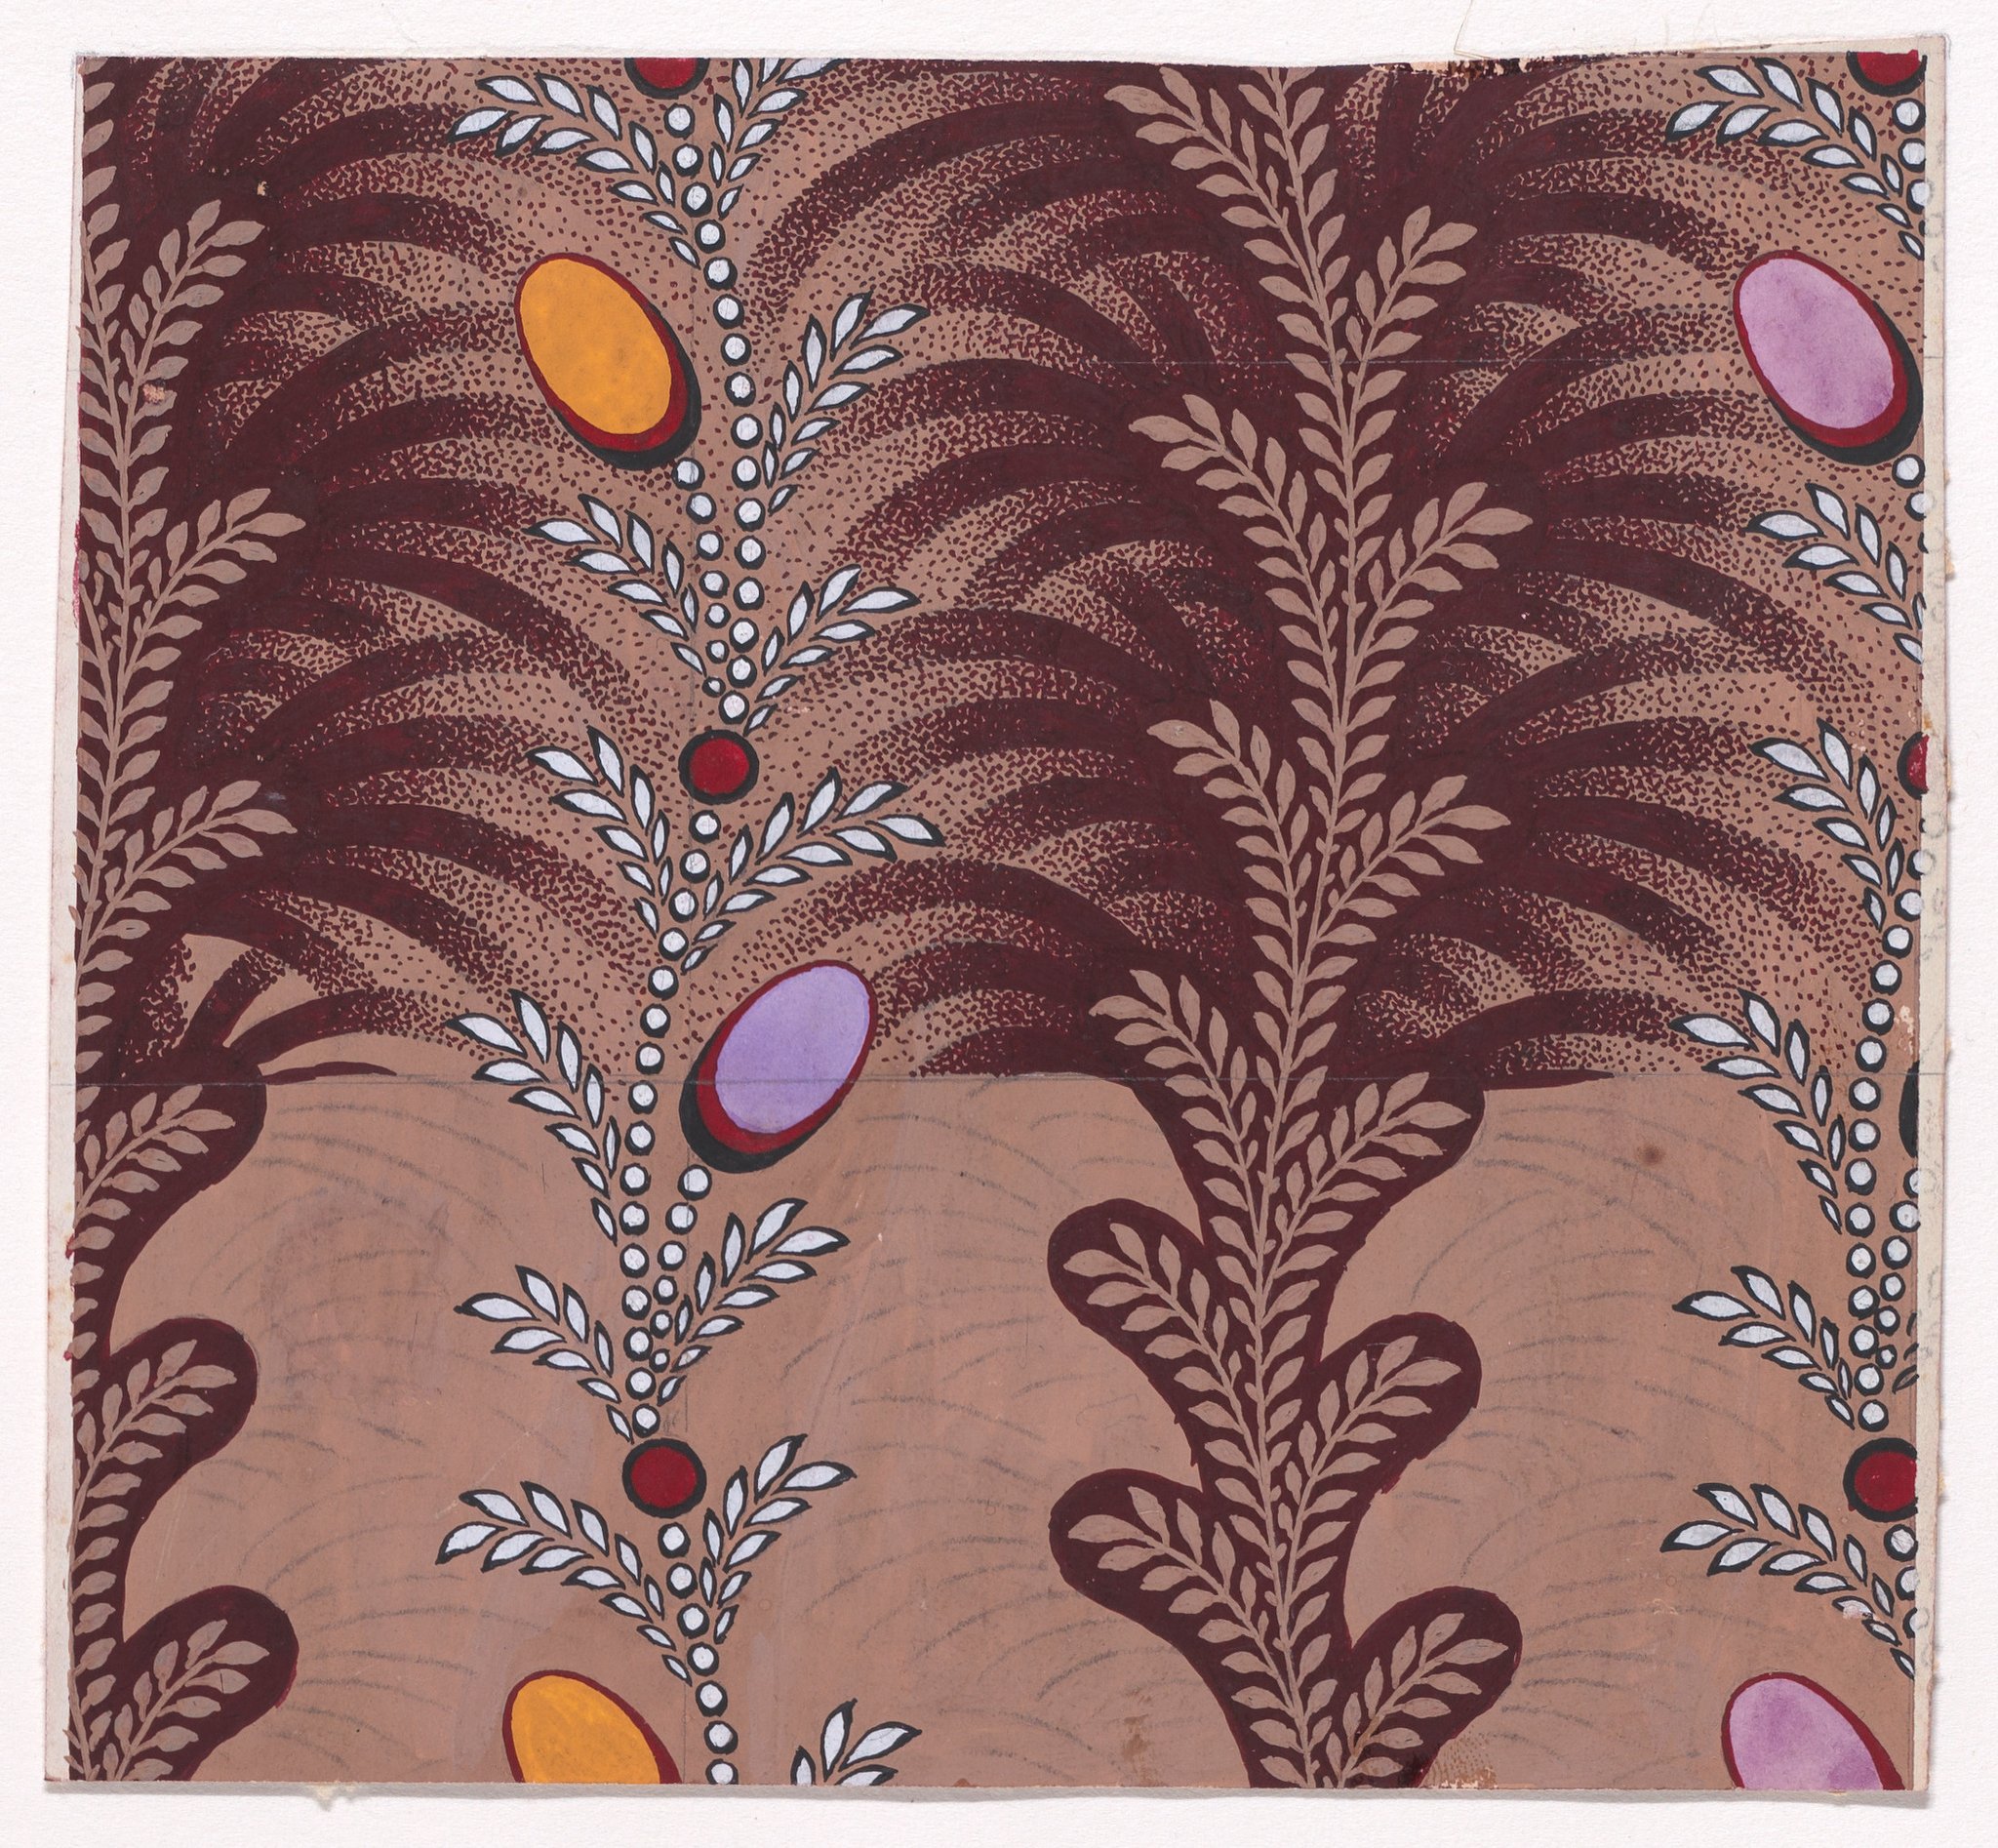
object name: drawing ornament architecture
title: Textile Design with Alternating Vertical Garlands of Stylized Leaves and Undulating Strips of Pearls with Offsetting Stylized Leaves and Ovals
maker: anonymous, alsatian, 19th century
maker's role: artist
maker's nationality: alsatian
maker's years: 1800-1900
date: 1840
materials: gouache